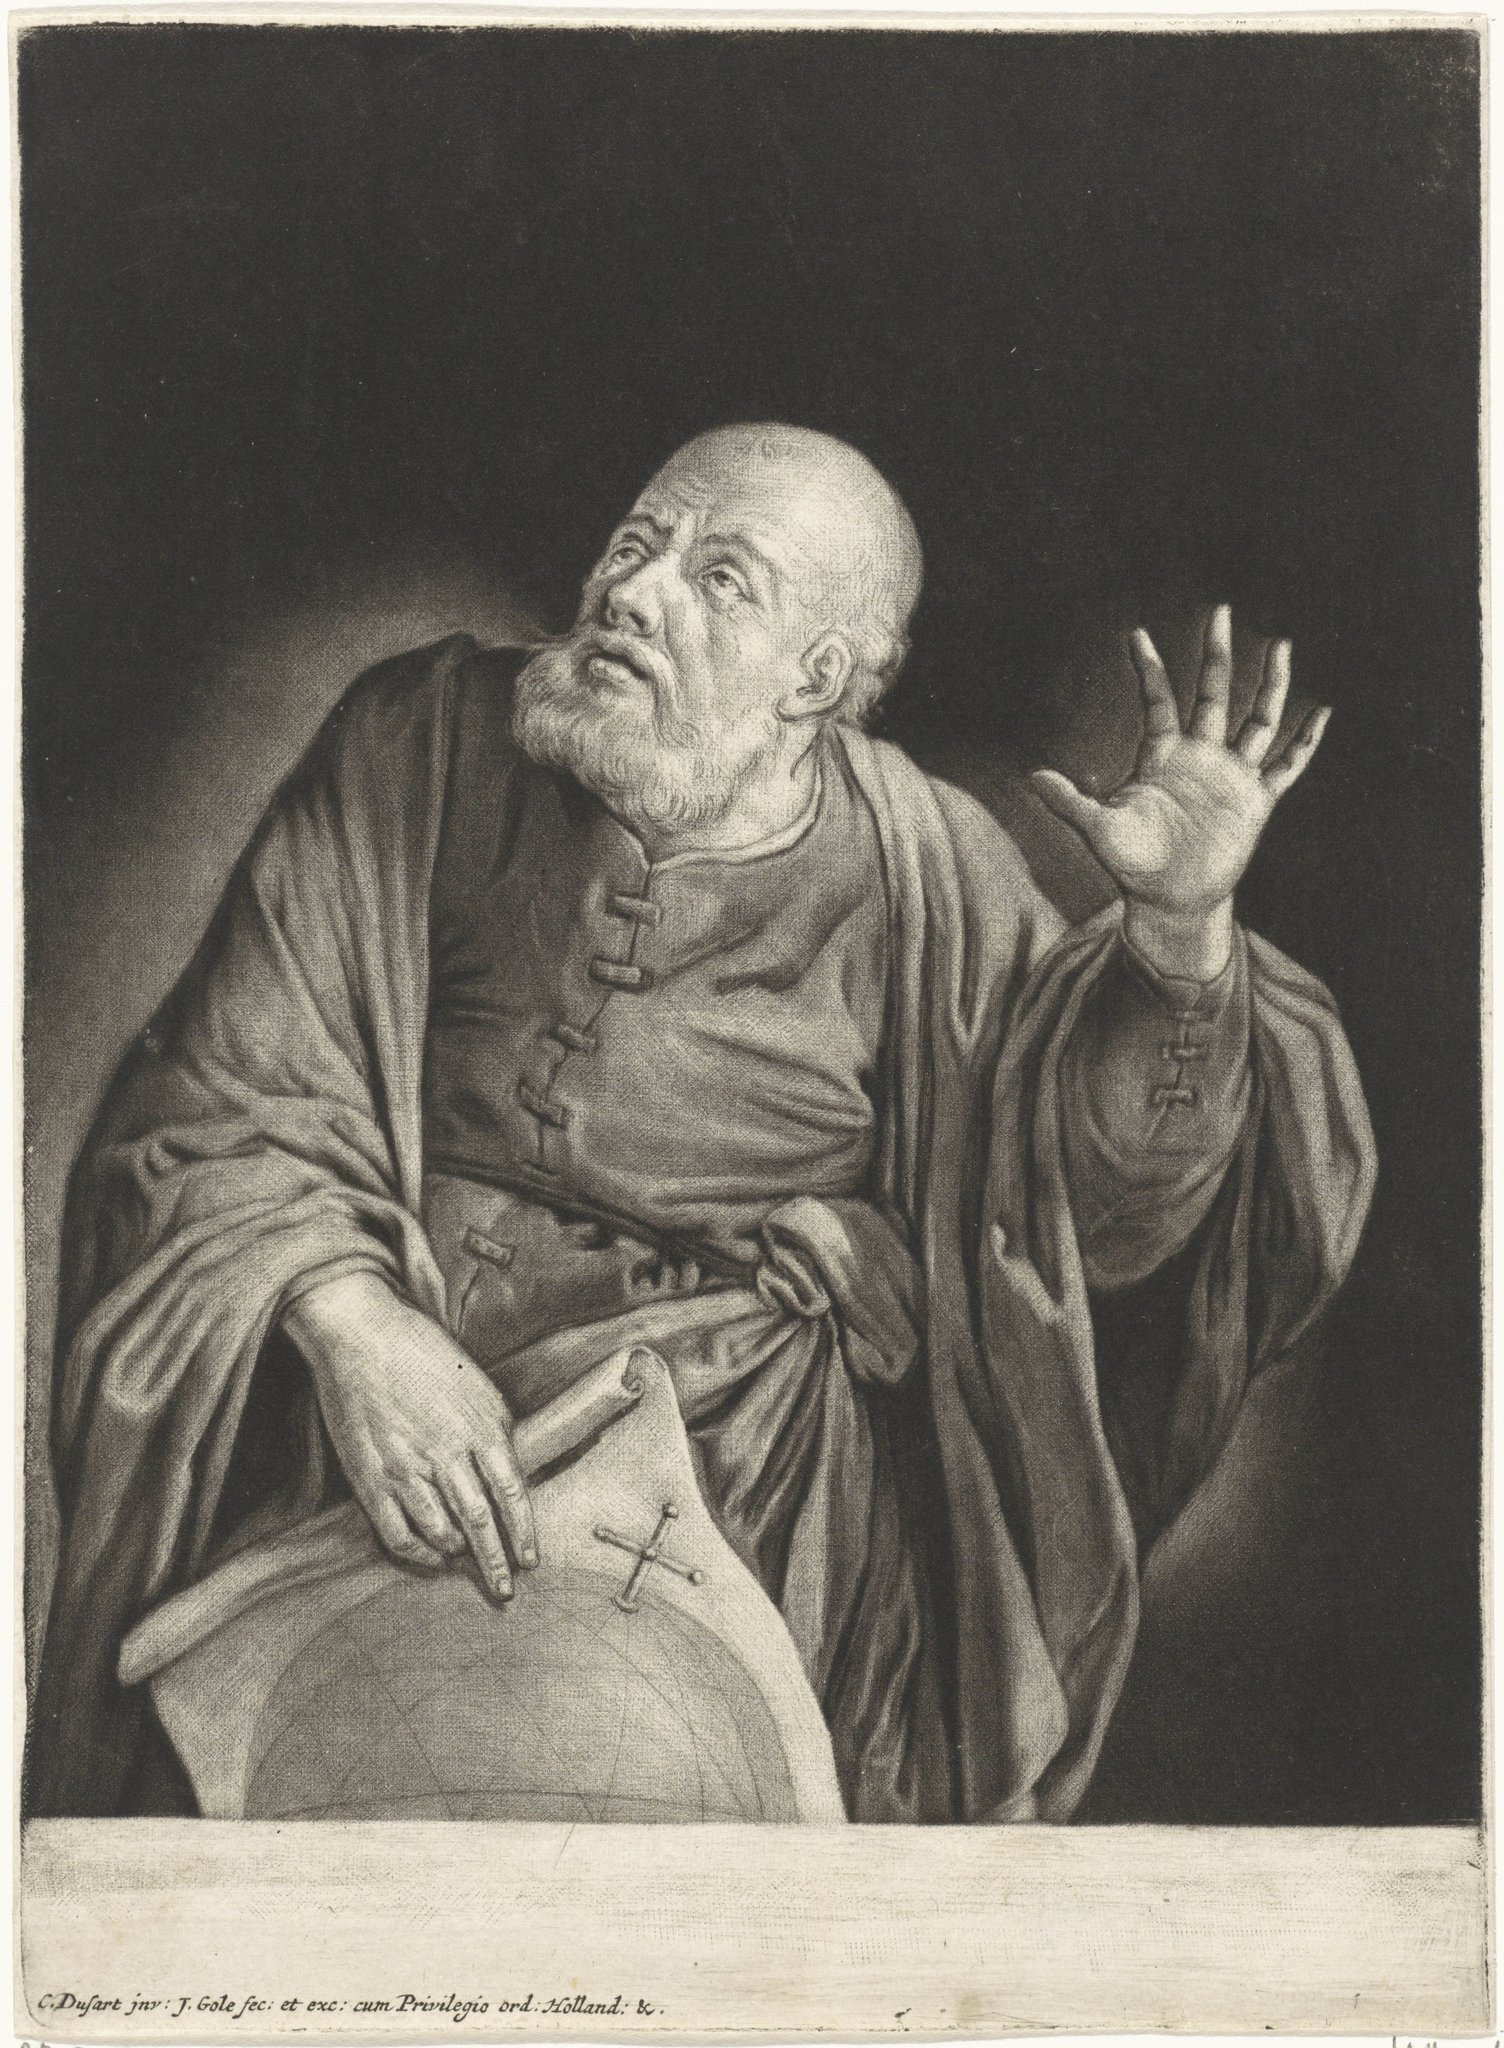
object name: print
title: Huilende Heraclitus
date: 1670-1724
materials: paper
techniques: engraving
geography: amsterdam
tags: (story of) heraclitus, the philosopher, crying, shouting, globe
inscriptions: collector's mark: Lugt 2228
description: De Griekse filosoof Heraclitus zit bij een wereldbol en huilt.